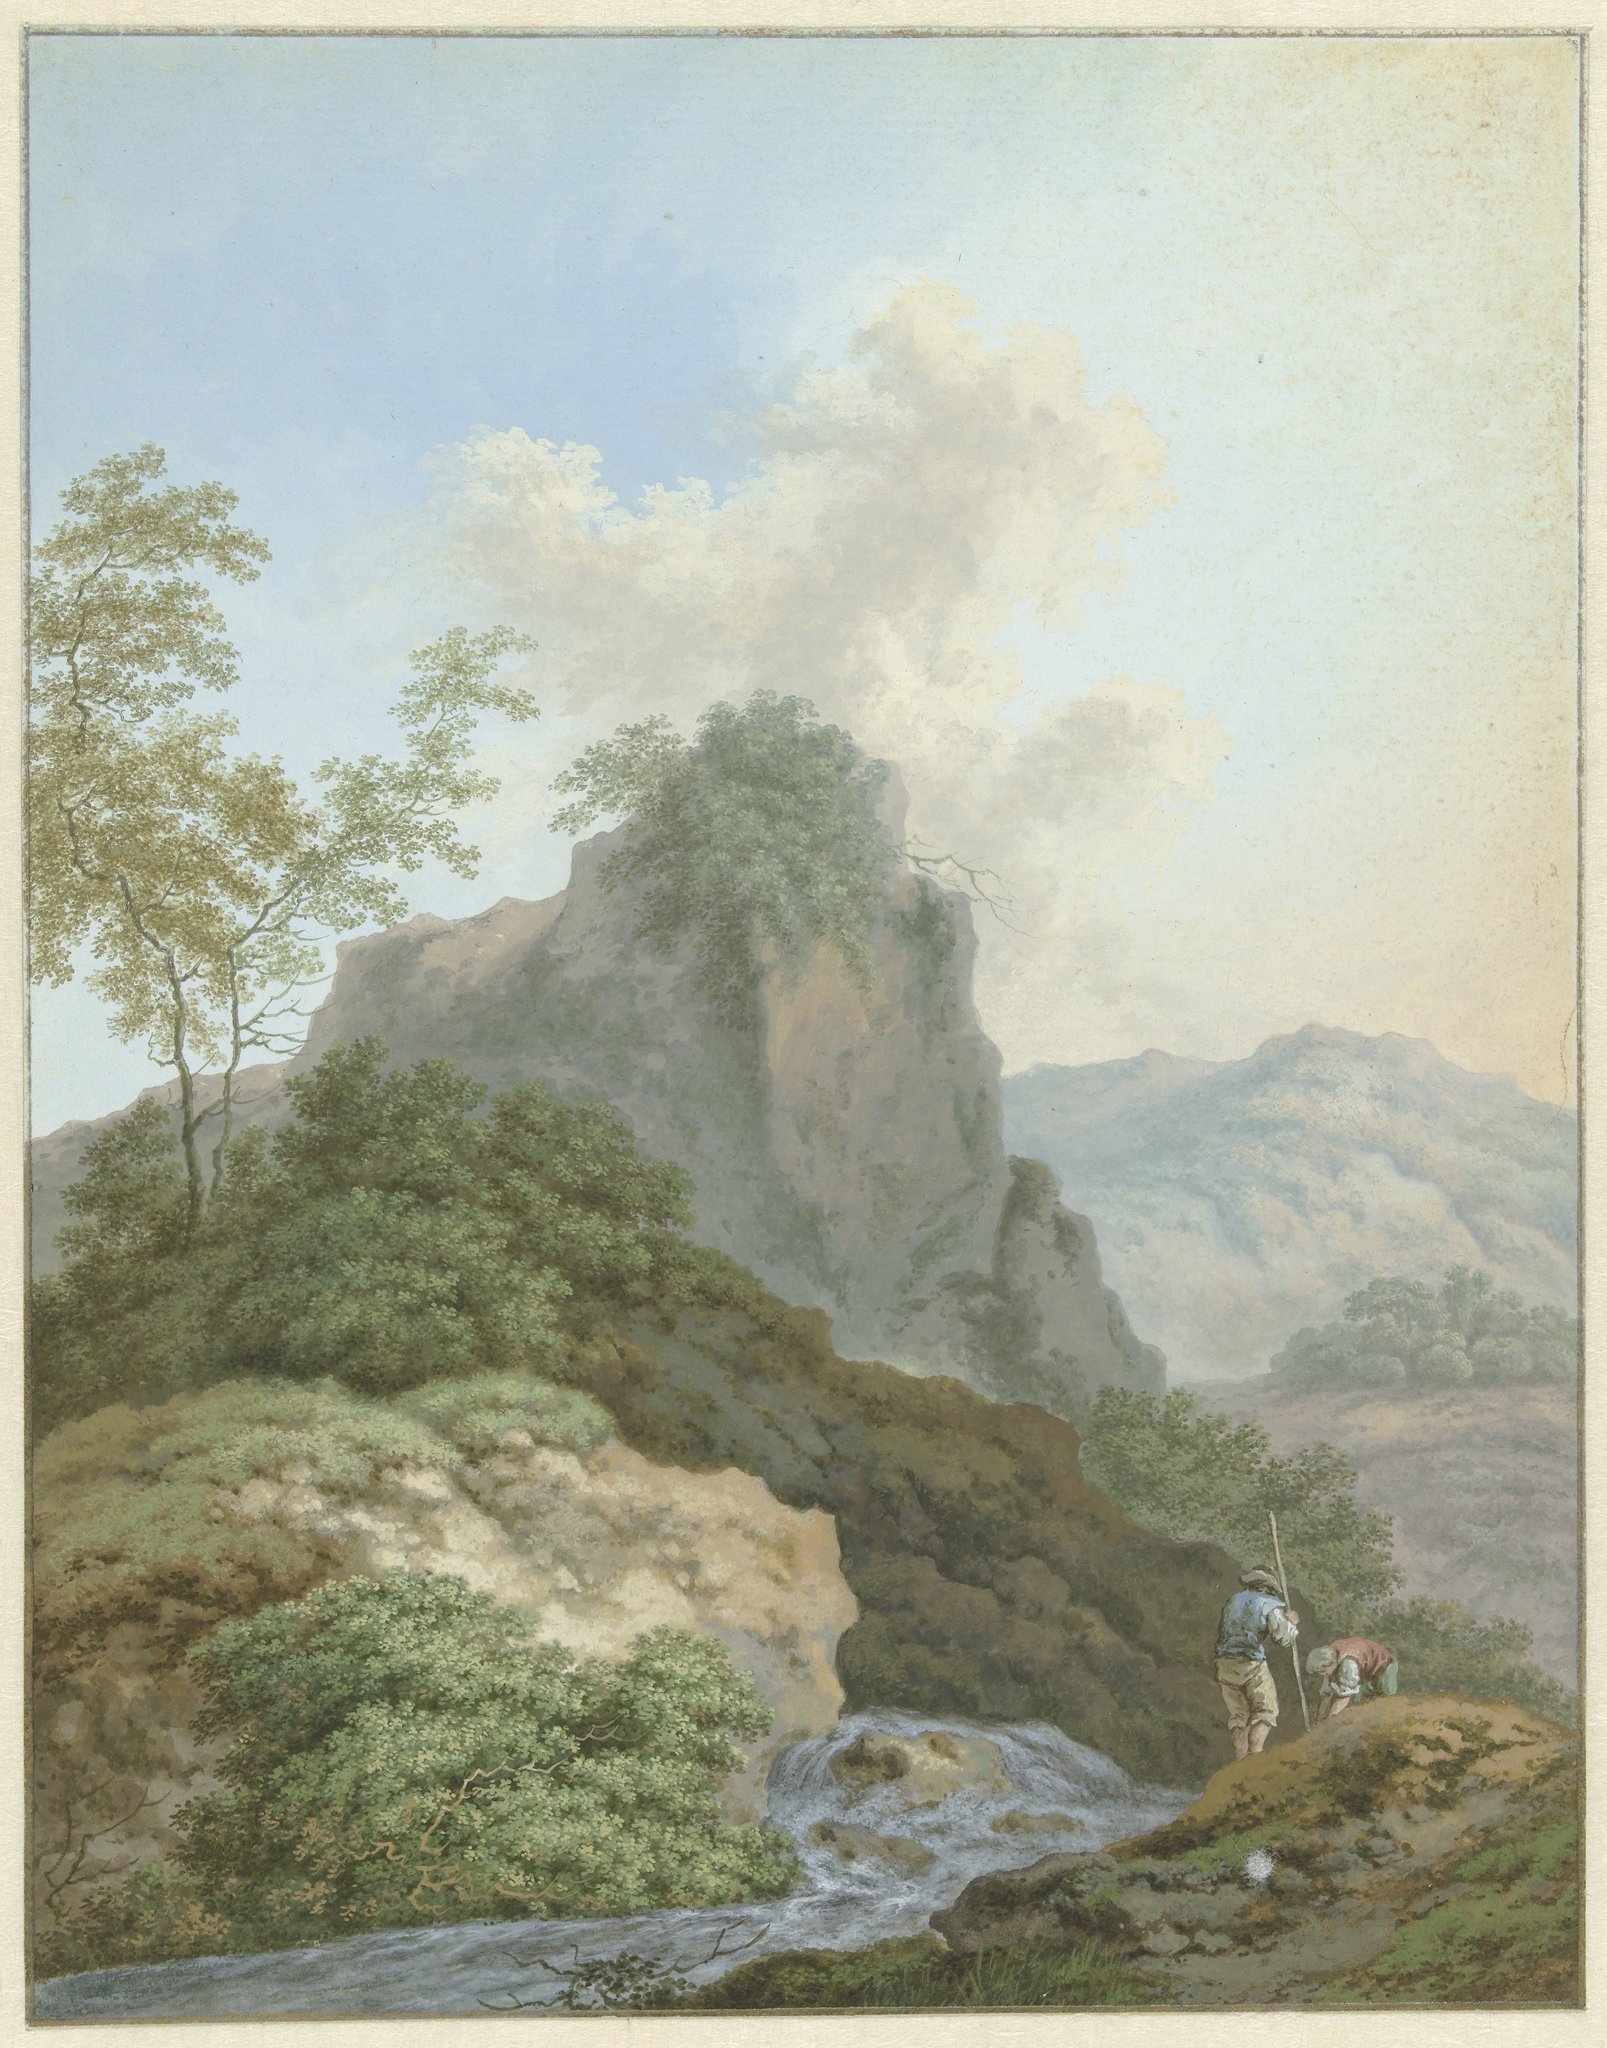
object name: drawing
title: Landschap met twee jongens bij een beek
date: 1700-1800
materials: gouache, paper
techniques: brush